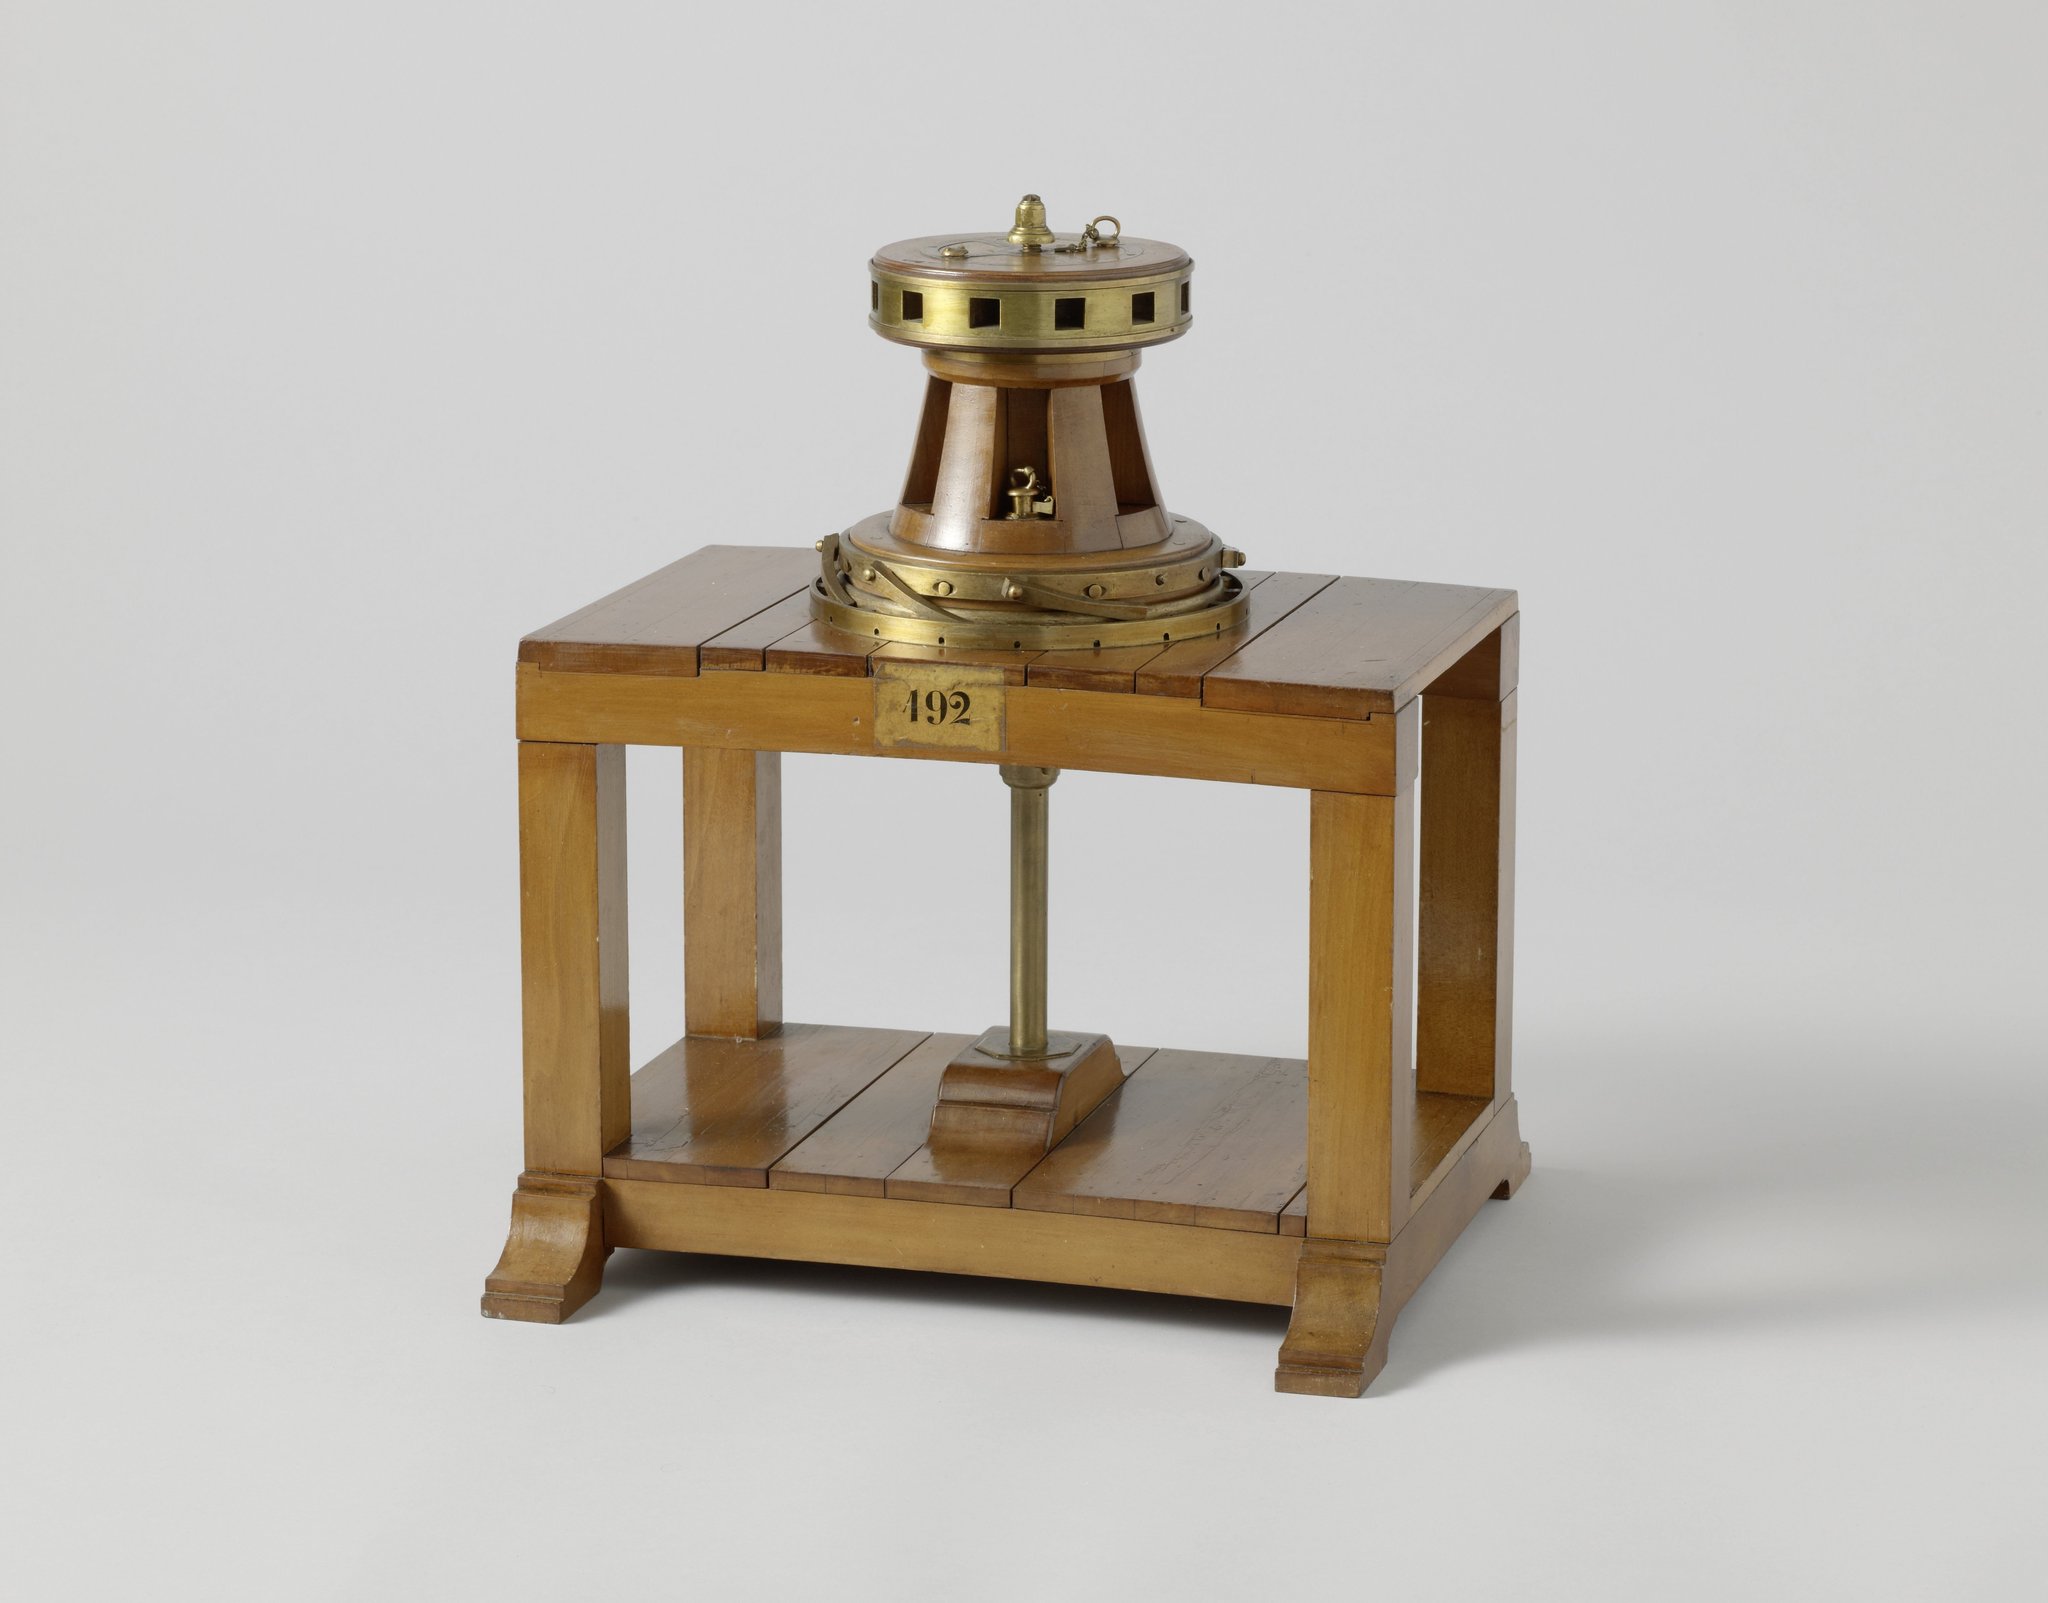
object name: demonstration model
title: Model of a Capstan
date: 1819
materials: brass, iron, wood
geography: flushing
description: Model van een kaapstander in een houten frame dat twee dekken voorstelt. De kaapstander is voor twaalf windbomen en heeft acht pallen in de hiel tegen het teruglopen. De metalen koning loopt door tot in een spoor op het onderste dek. Deze kaapstander heeft twee snelheden, die verkregen worden door de pallen in de kop en in de hiel neer te laten of op te tillen; het raderwerk, bestaande uit zon-en-planeetraderen, is onder het bovendek tussen de balken van de vissing geplaatst. Schaal 1:10.